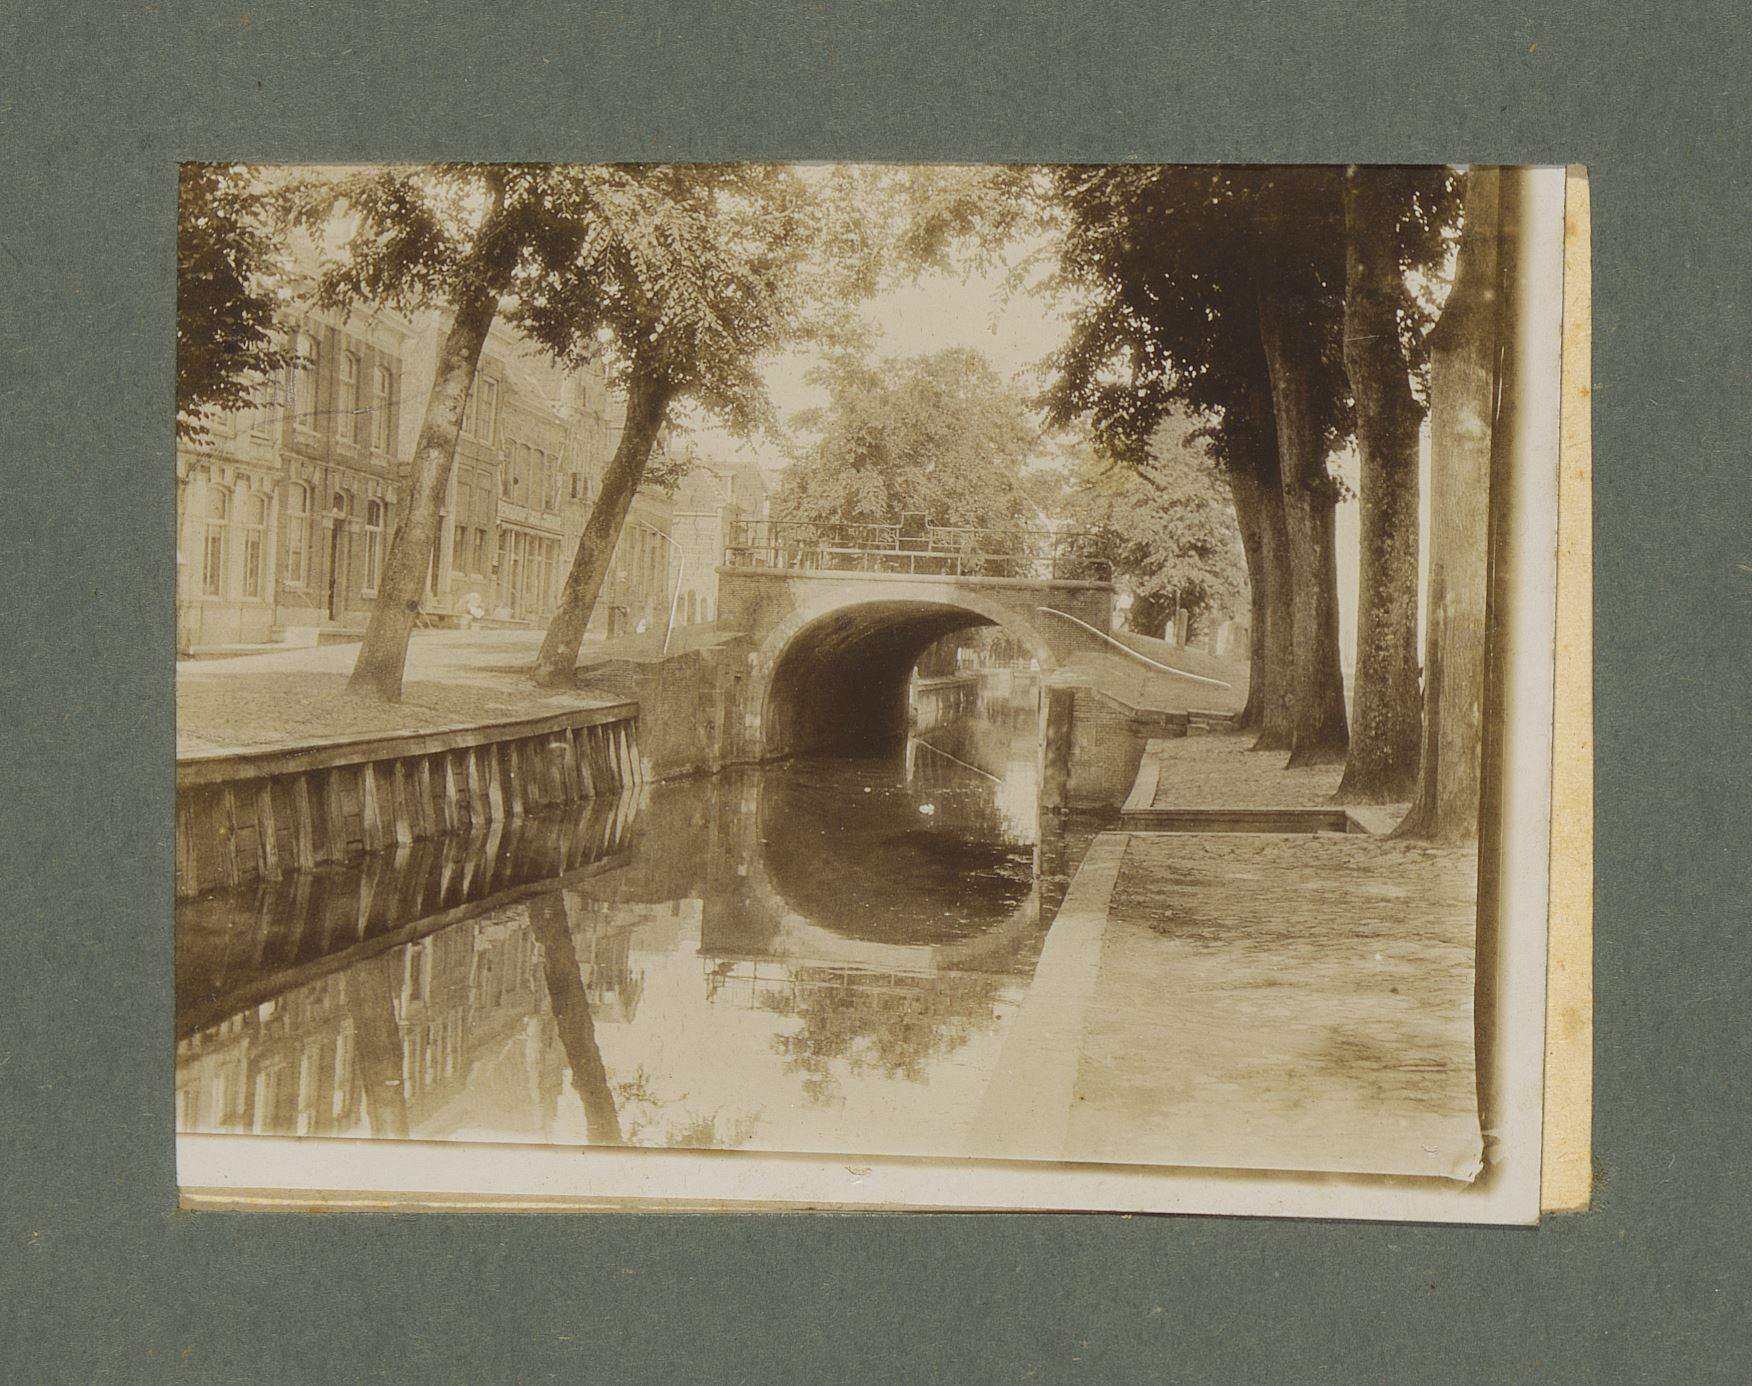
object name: album leaf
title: Gezicht op een brug over een gracht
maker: george hidderley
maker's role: fotograaf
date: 1920-1940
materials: photographic support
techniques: gelatin silver print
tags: canals, waters (in city), bridge